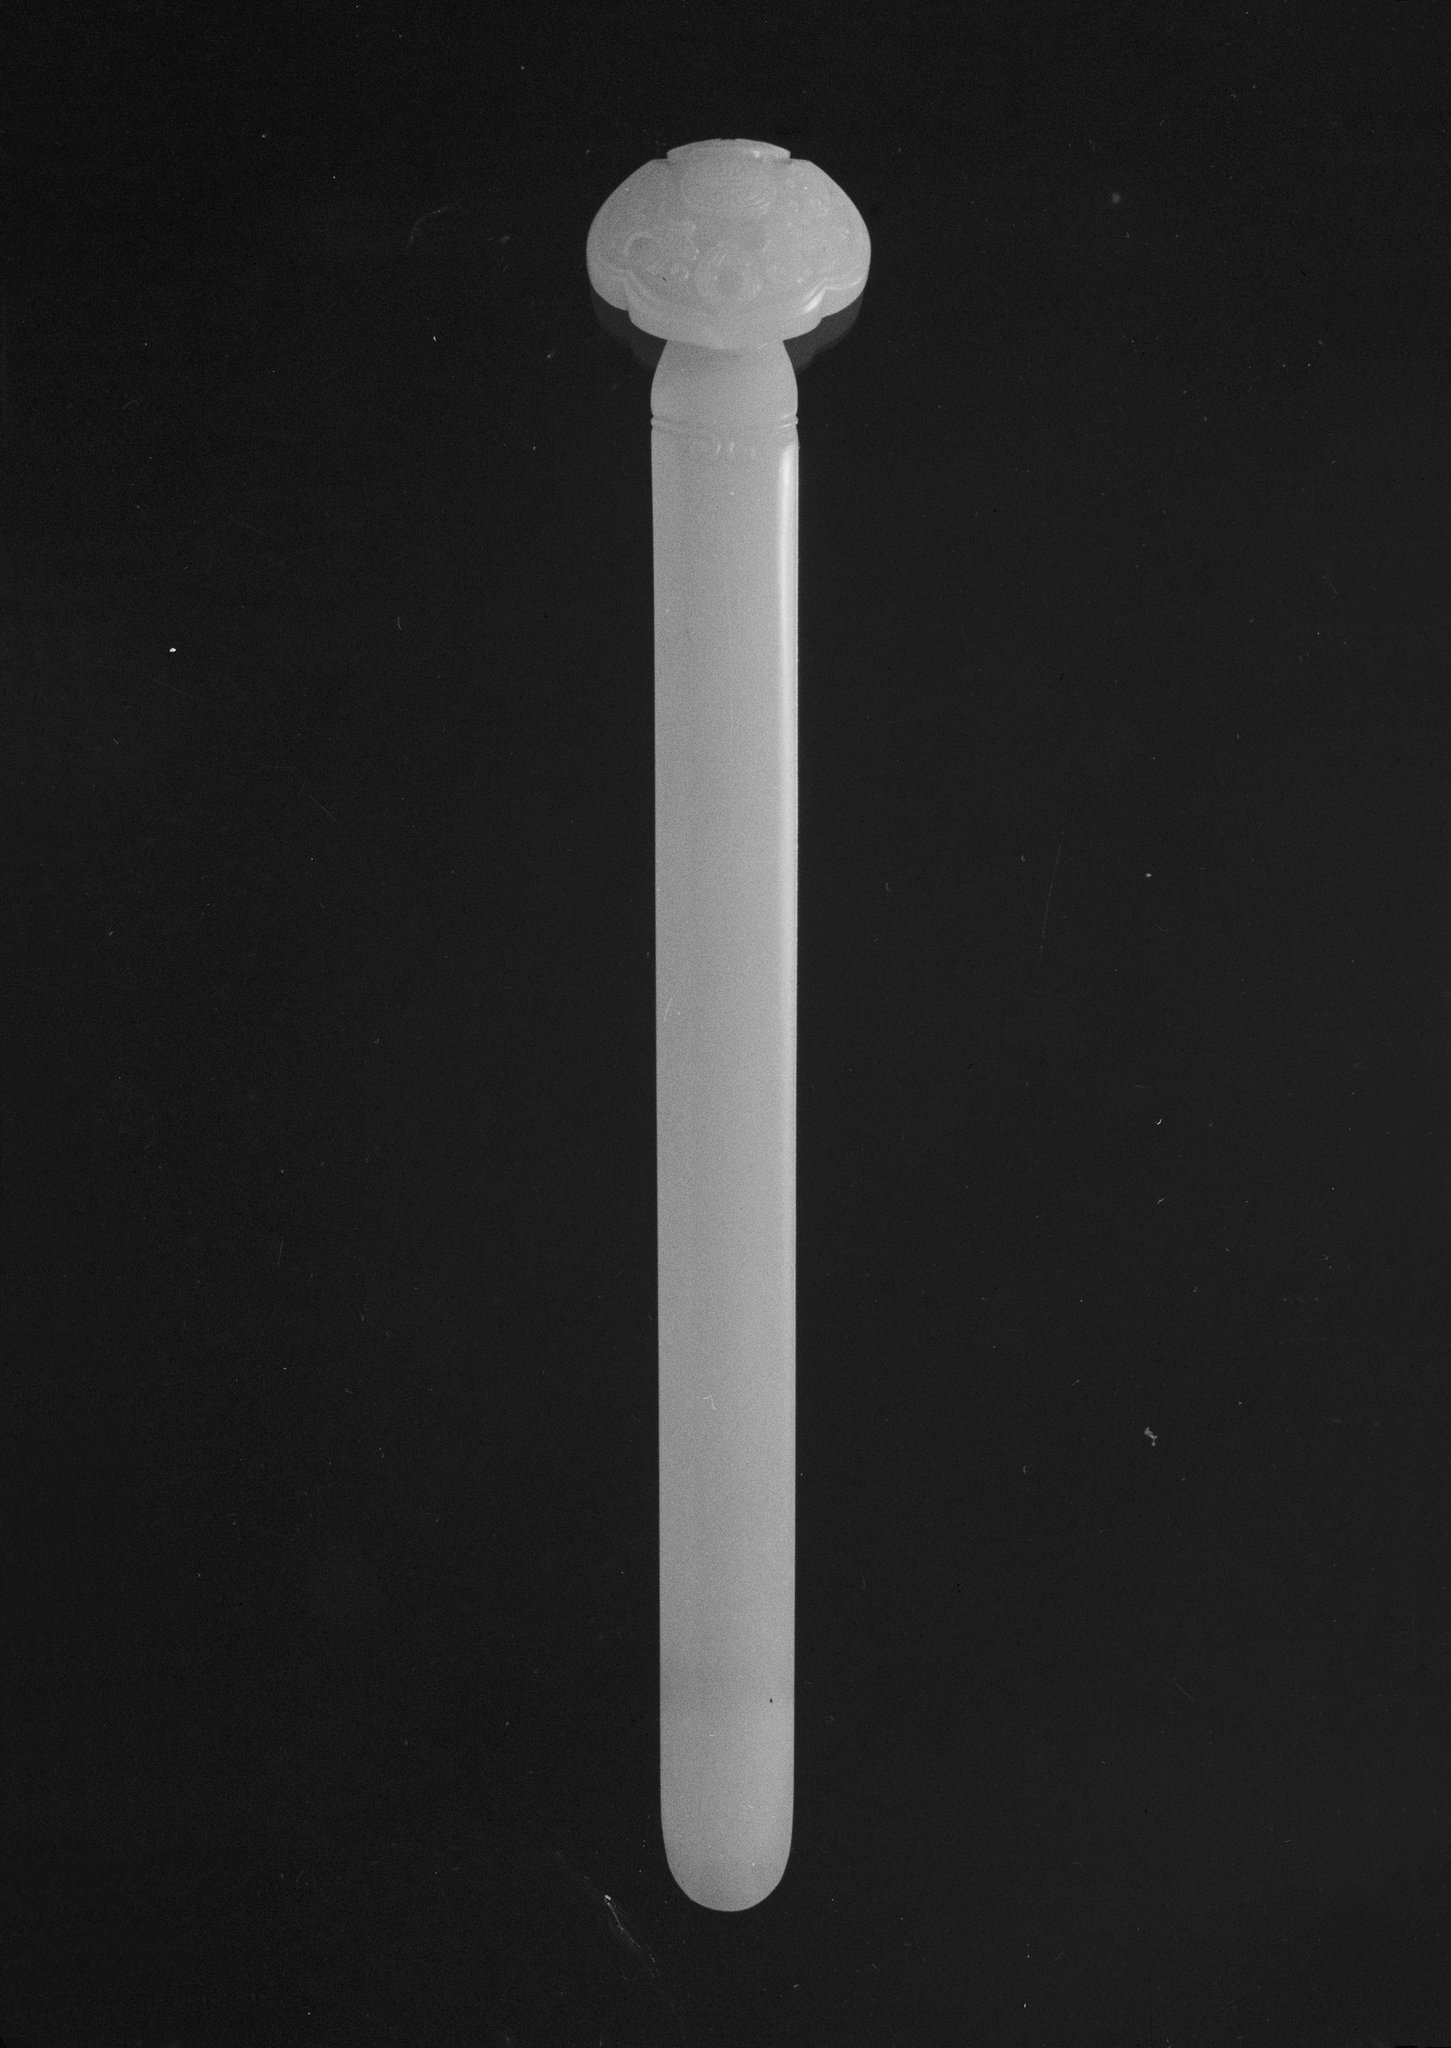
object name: hairpin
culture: chinese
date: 1801-1900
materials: jade